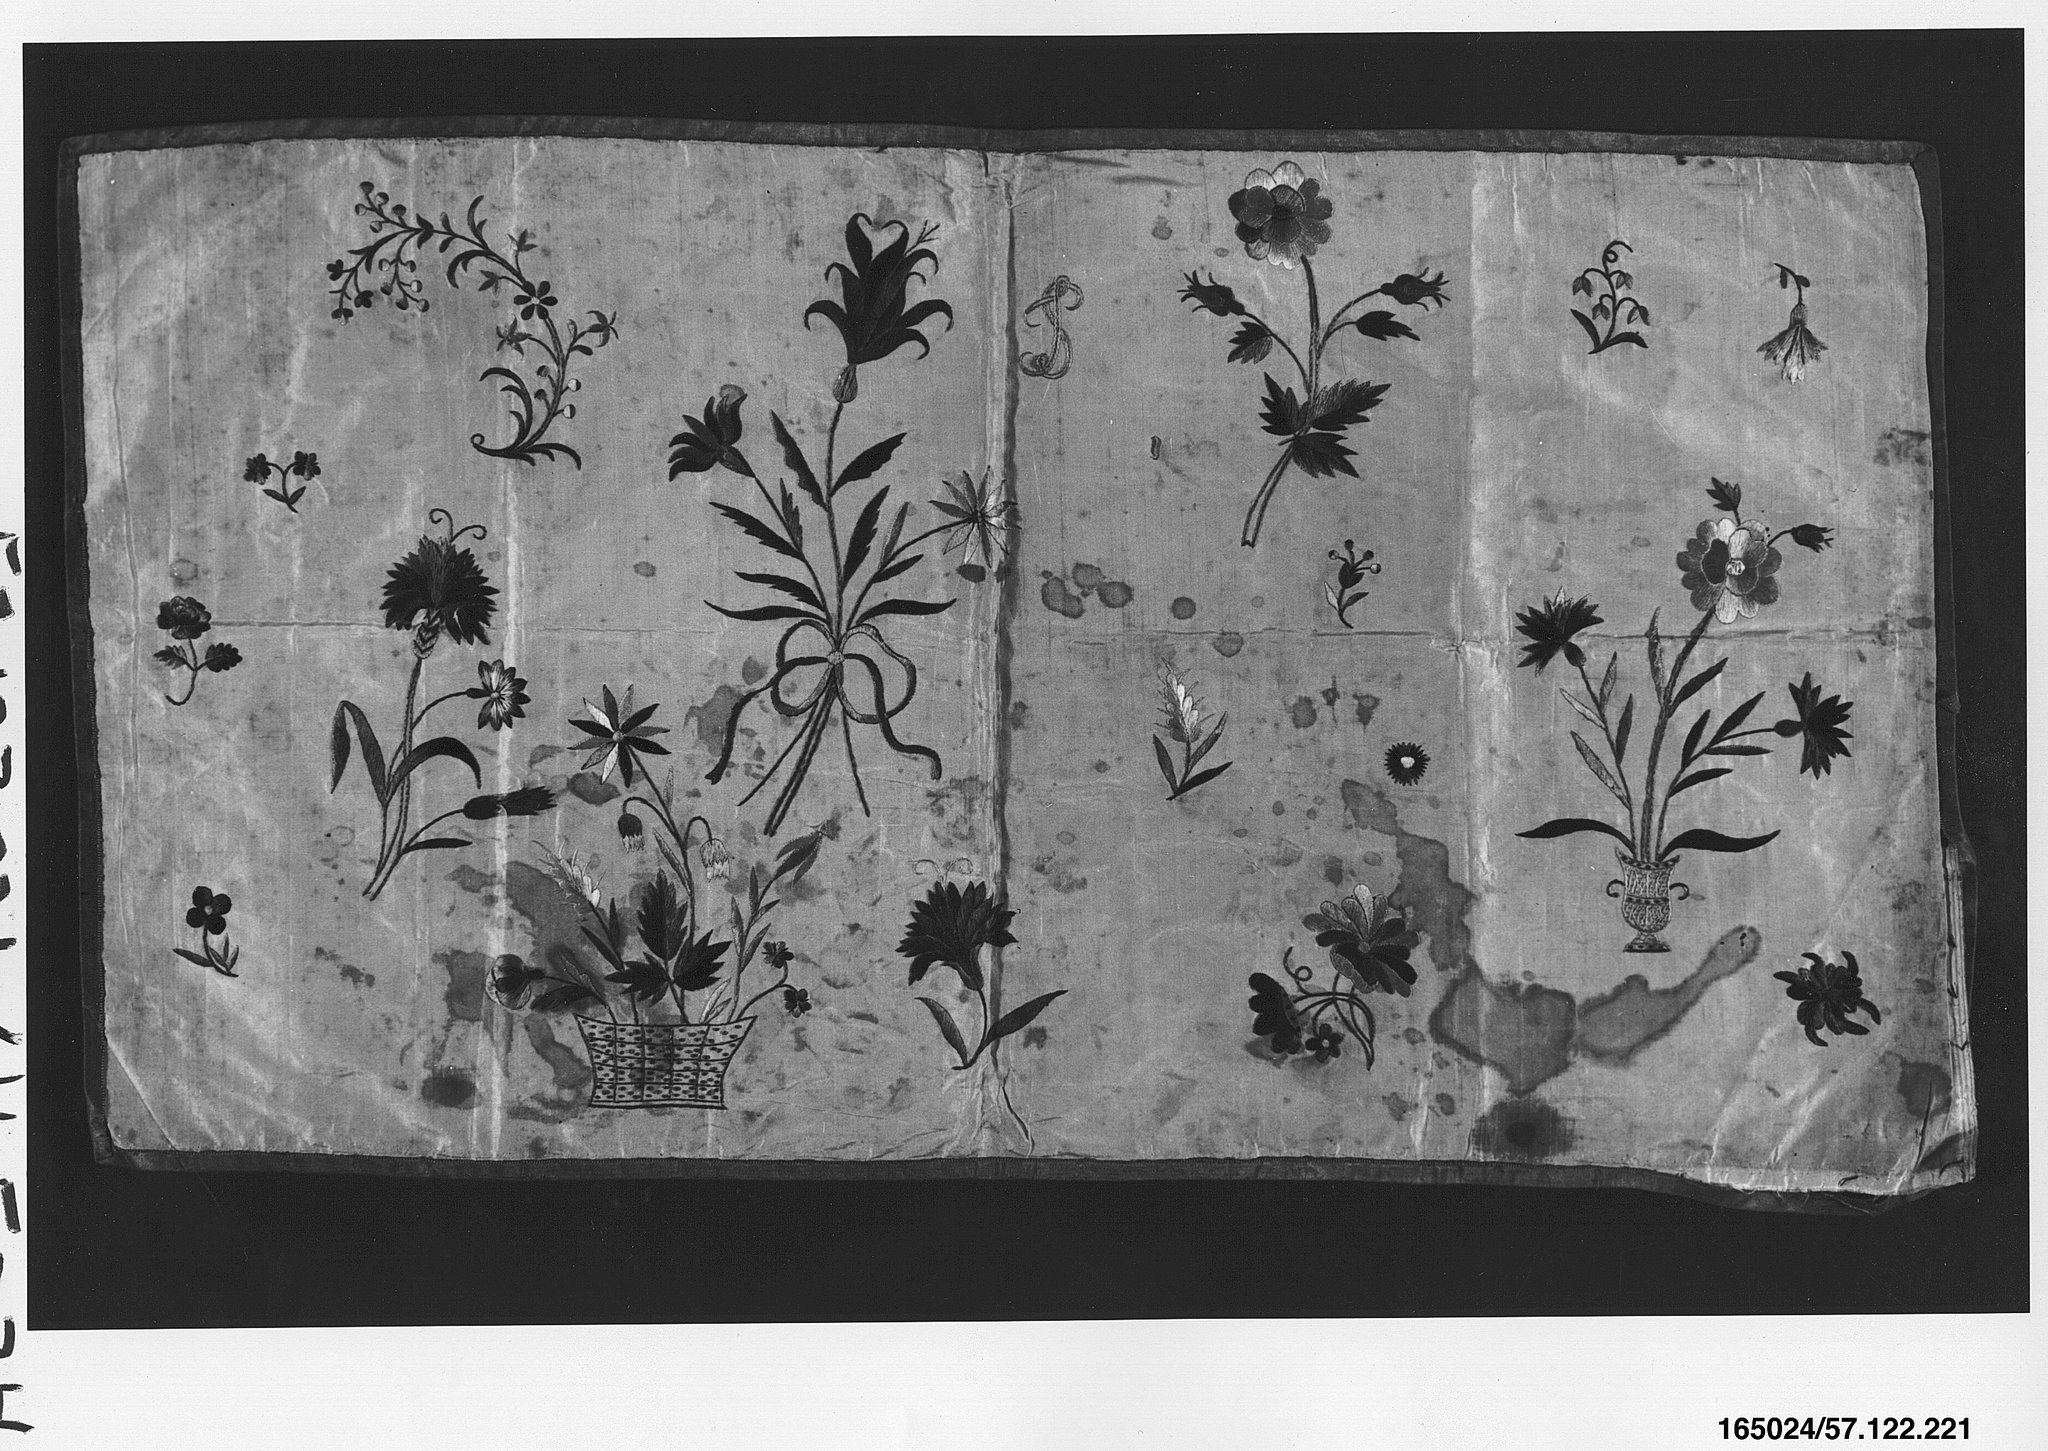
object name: sampler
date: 1801-1900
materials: silk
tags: flowers,leaves